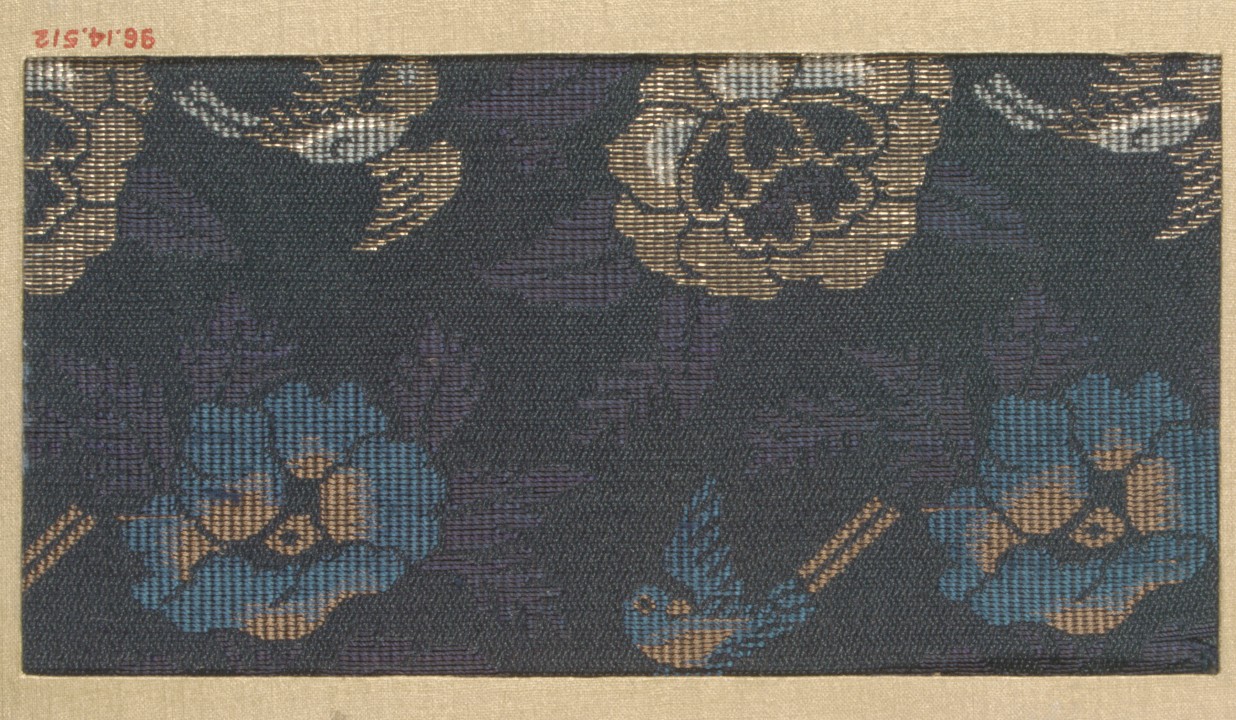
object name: piece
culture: japanese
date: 1701-1900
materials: silk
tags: birds